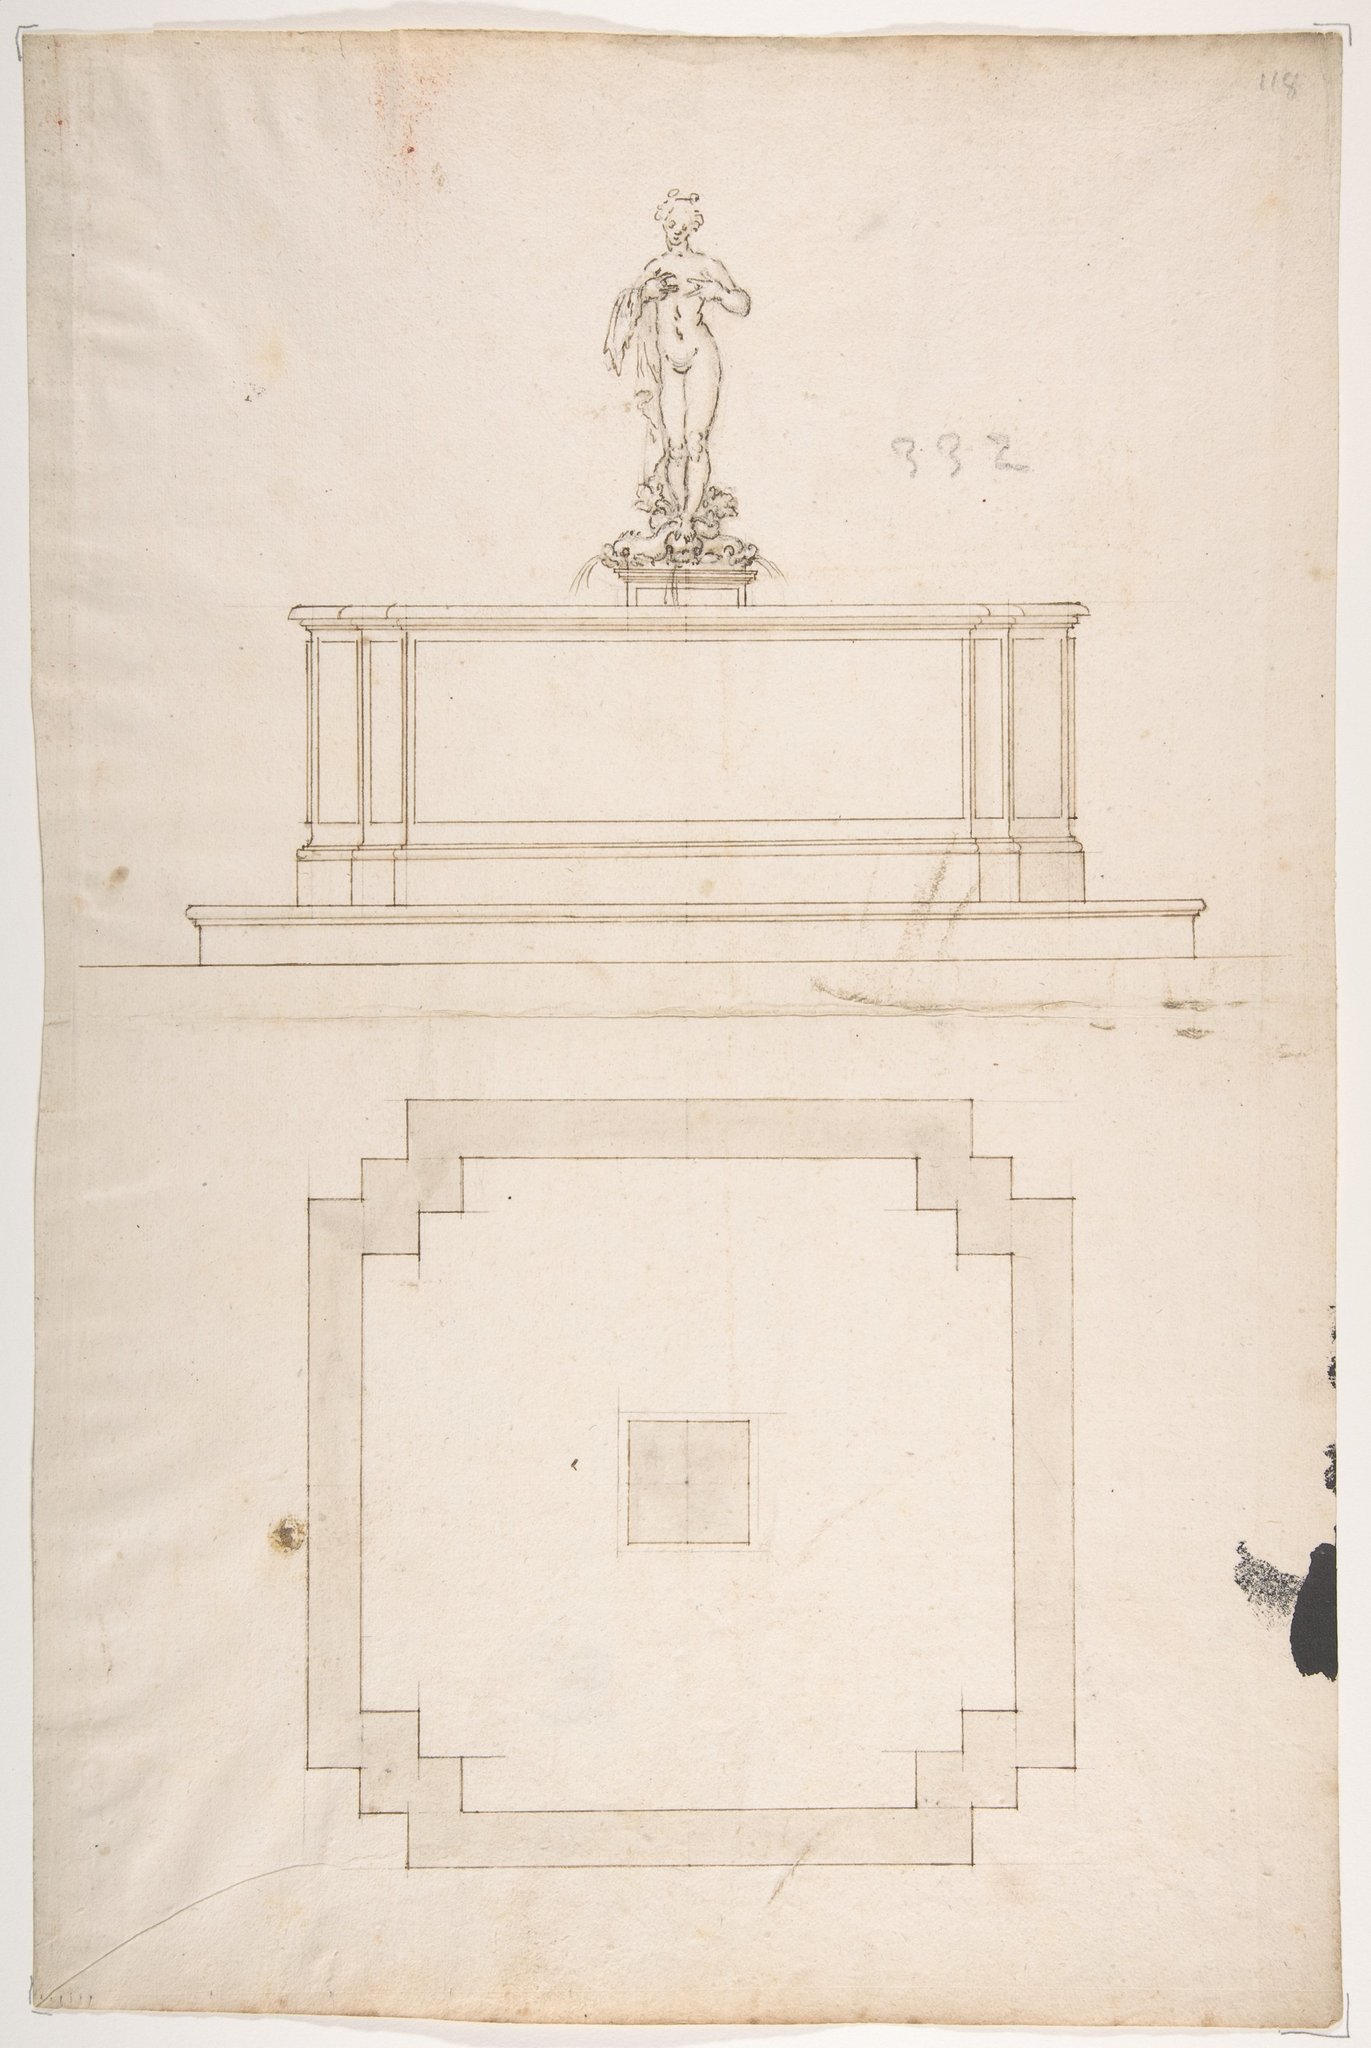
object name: drawing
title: Plan and Elevation for a Fountain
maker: anonymous, french, 16th century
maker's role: artist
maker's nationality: french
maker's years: 1500-1600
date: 1501-1600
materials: chalk, ink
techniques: brush, pen, wash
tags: architecture,fountains